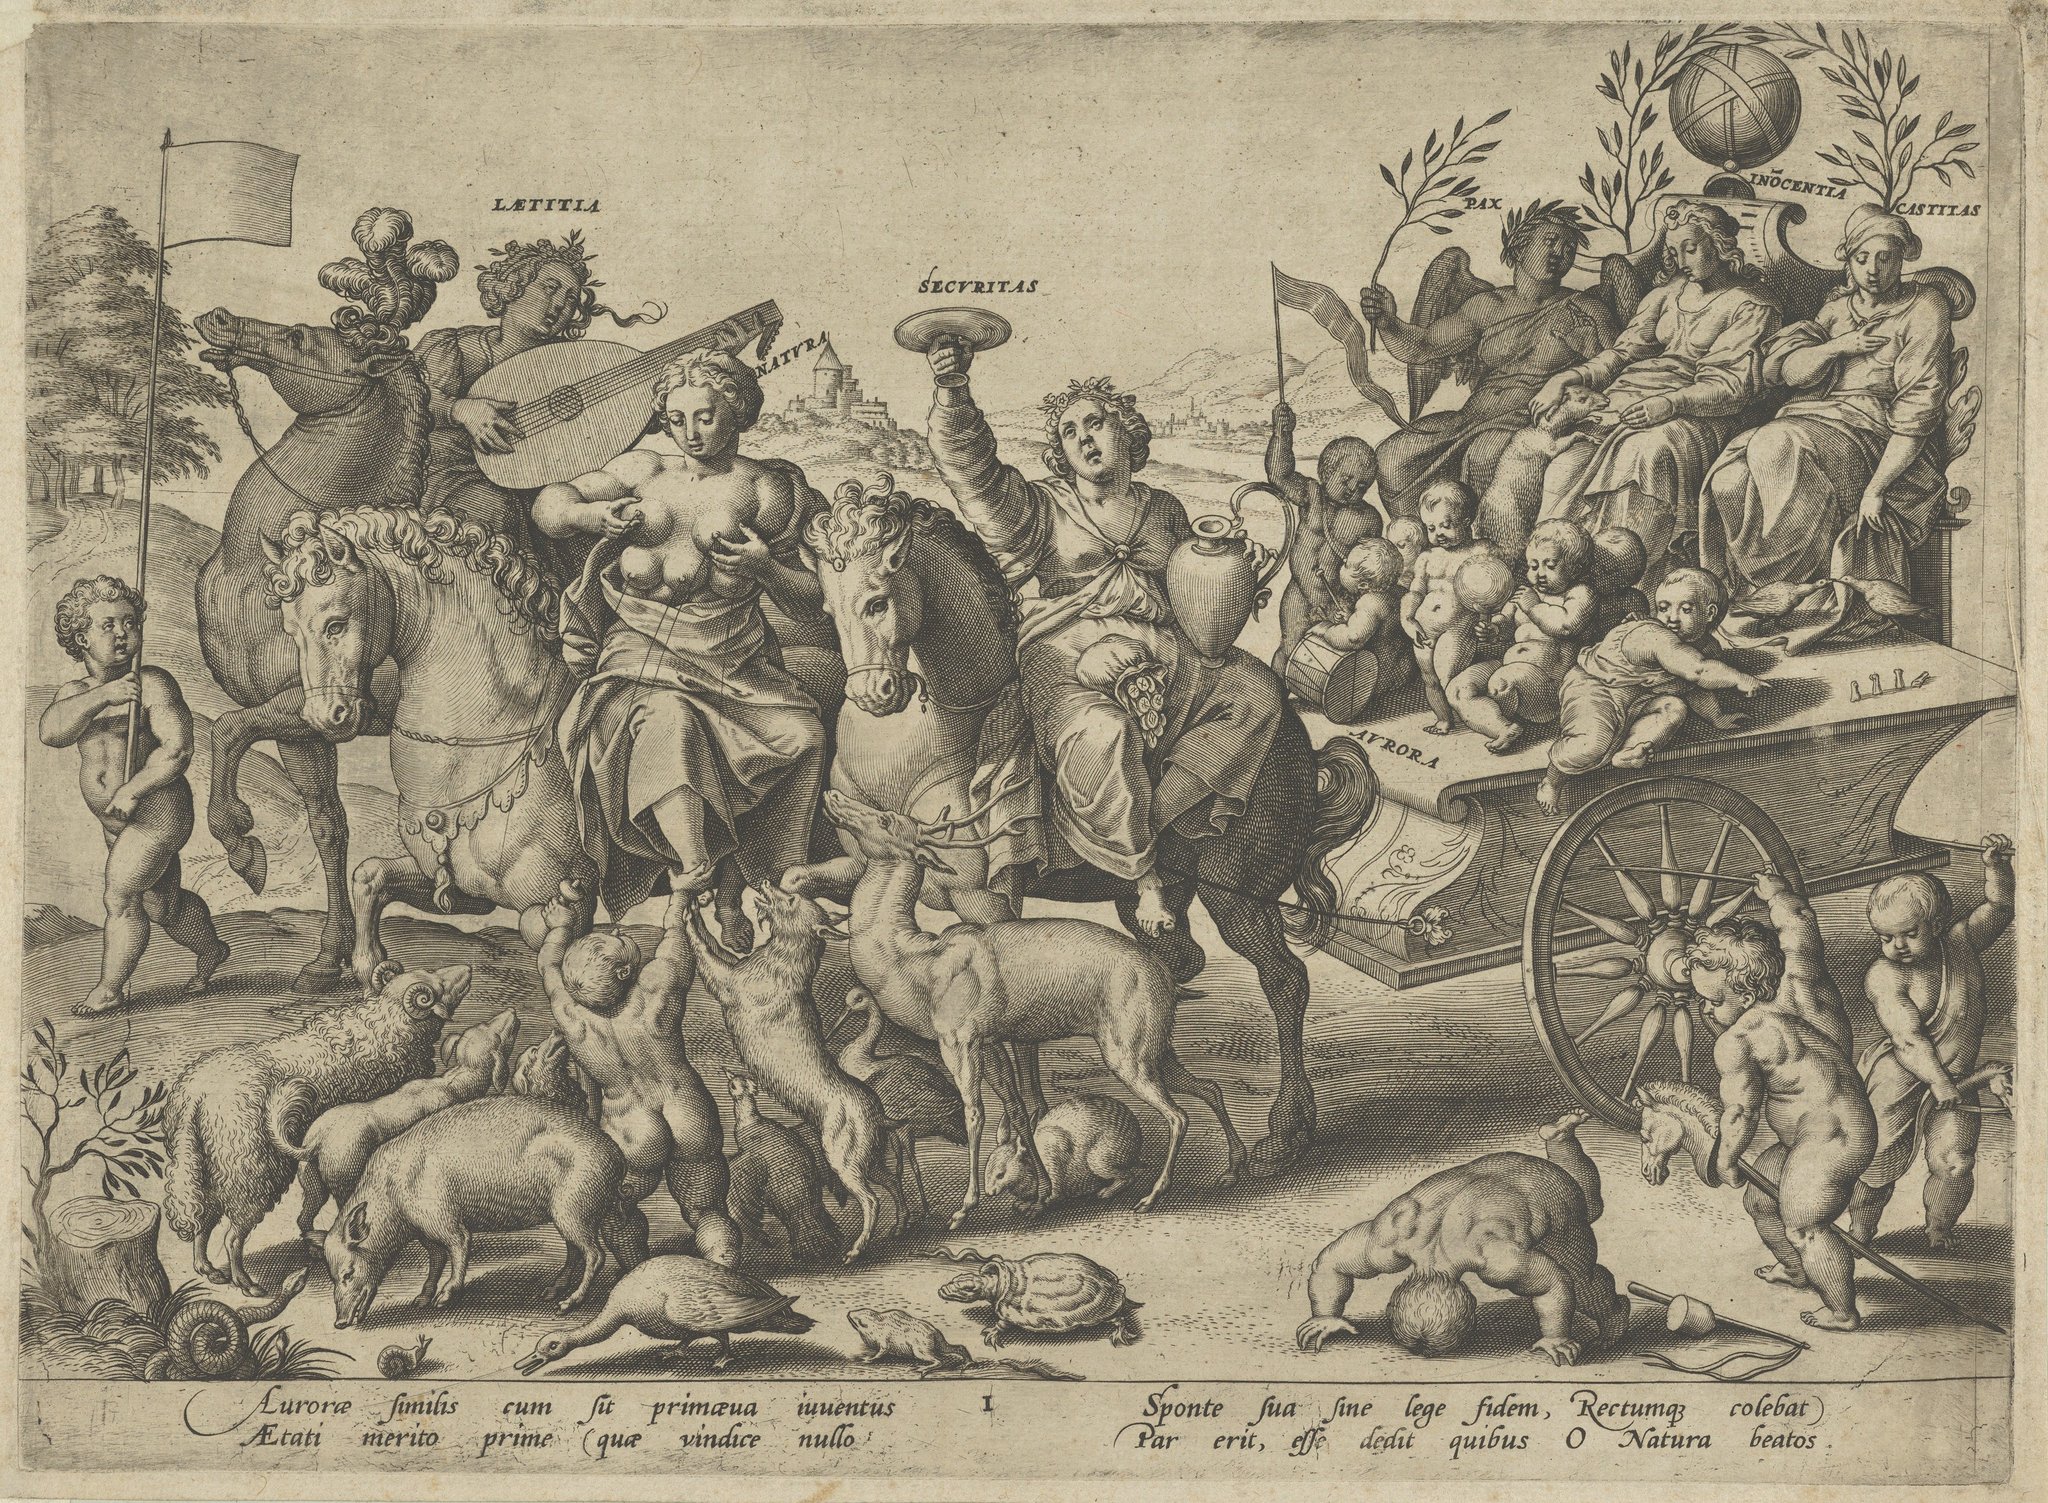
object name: print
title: Childhood (Dawn), from "The Four Ages of Man and Death with the Last Judgment"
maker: hieronymus wierix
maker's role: artist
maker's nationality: netherlandish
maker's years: 1553-1619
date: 1619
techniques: engraving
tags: human figures,infants,last judgement,death,carriages